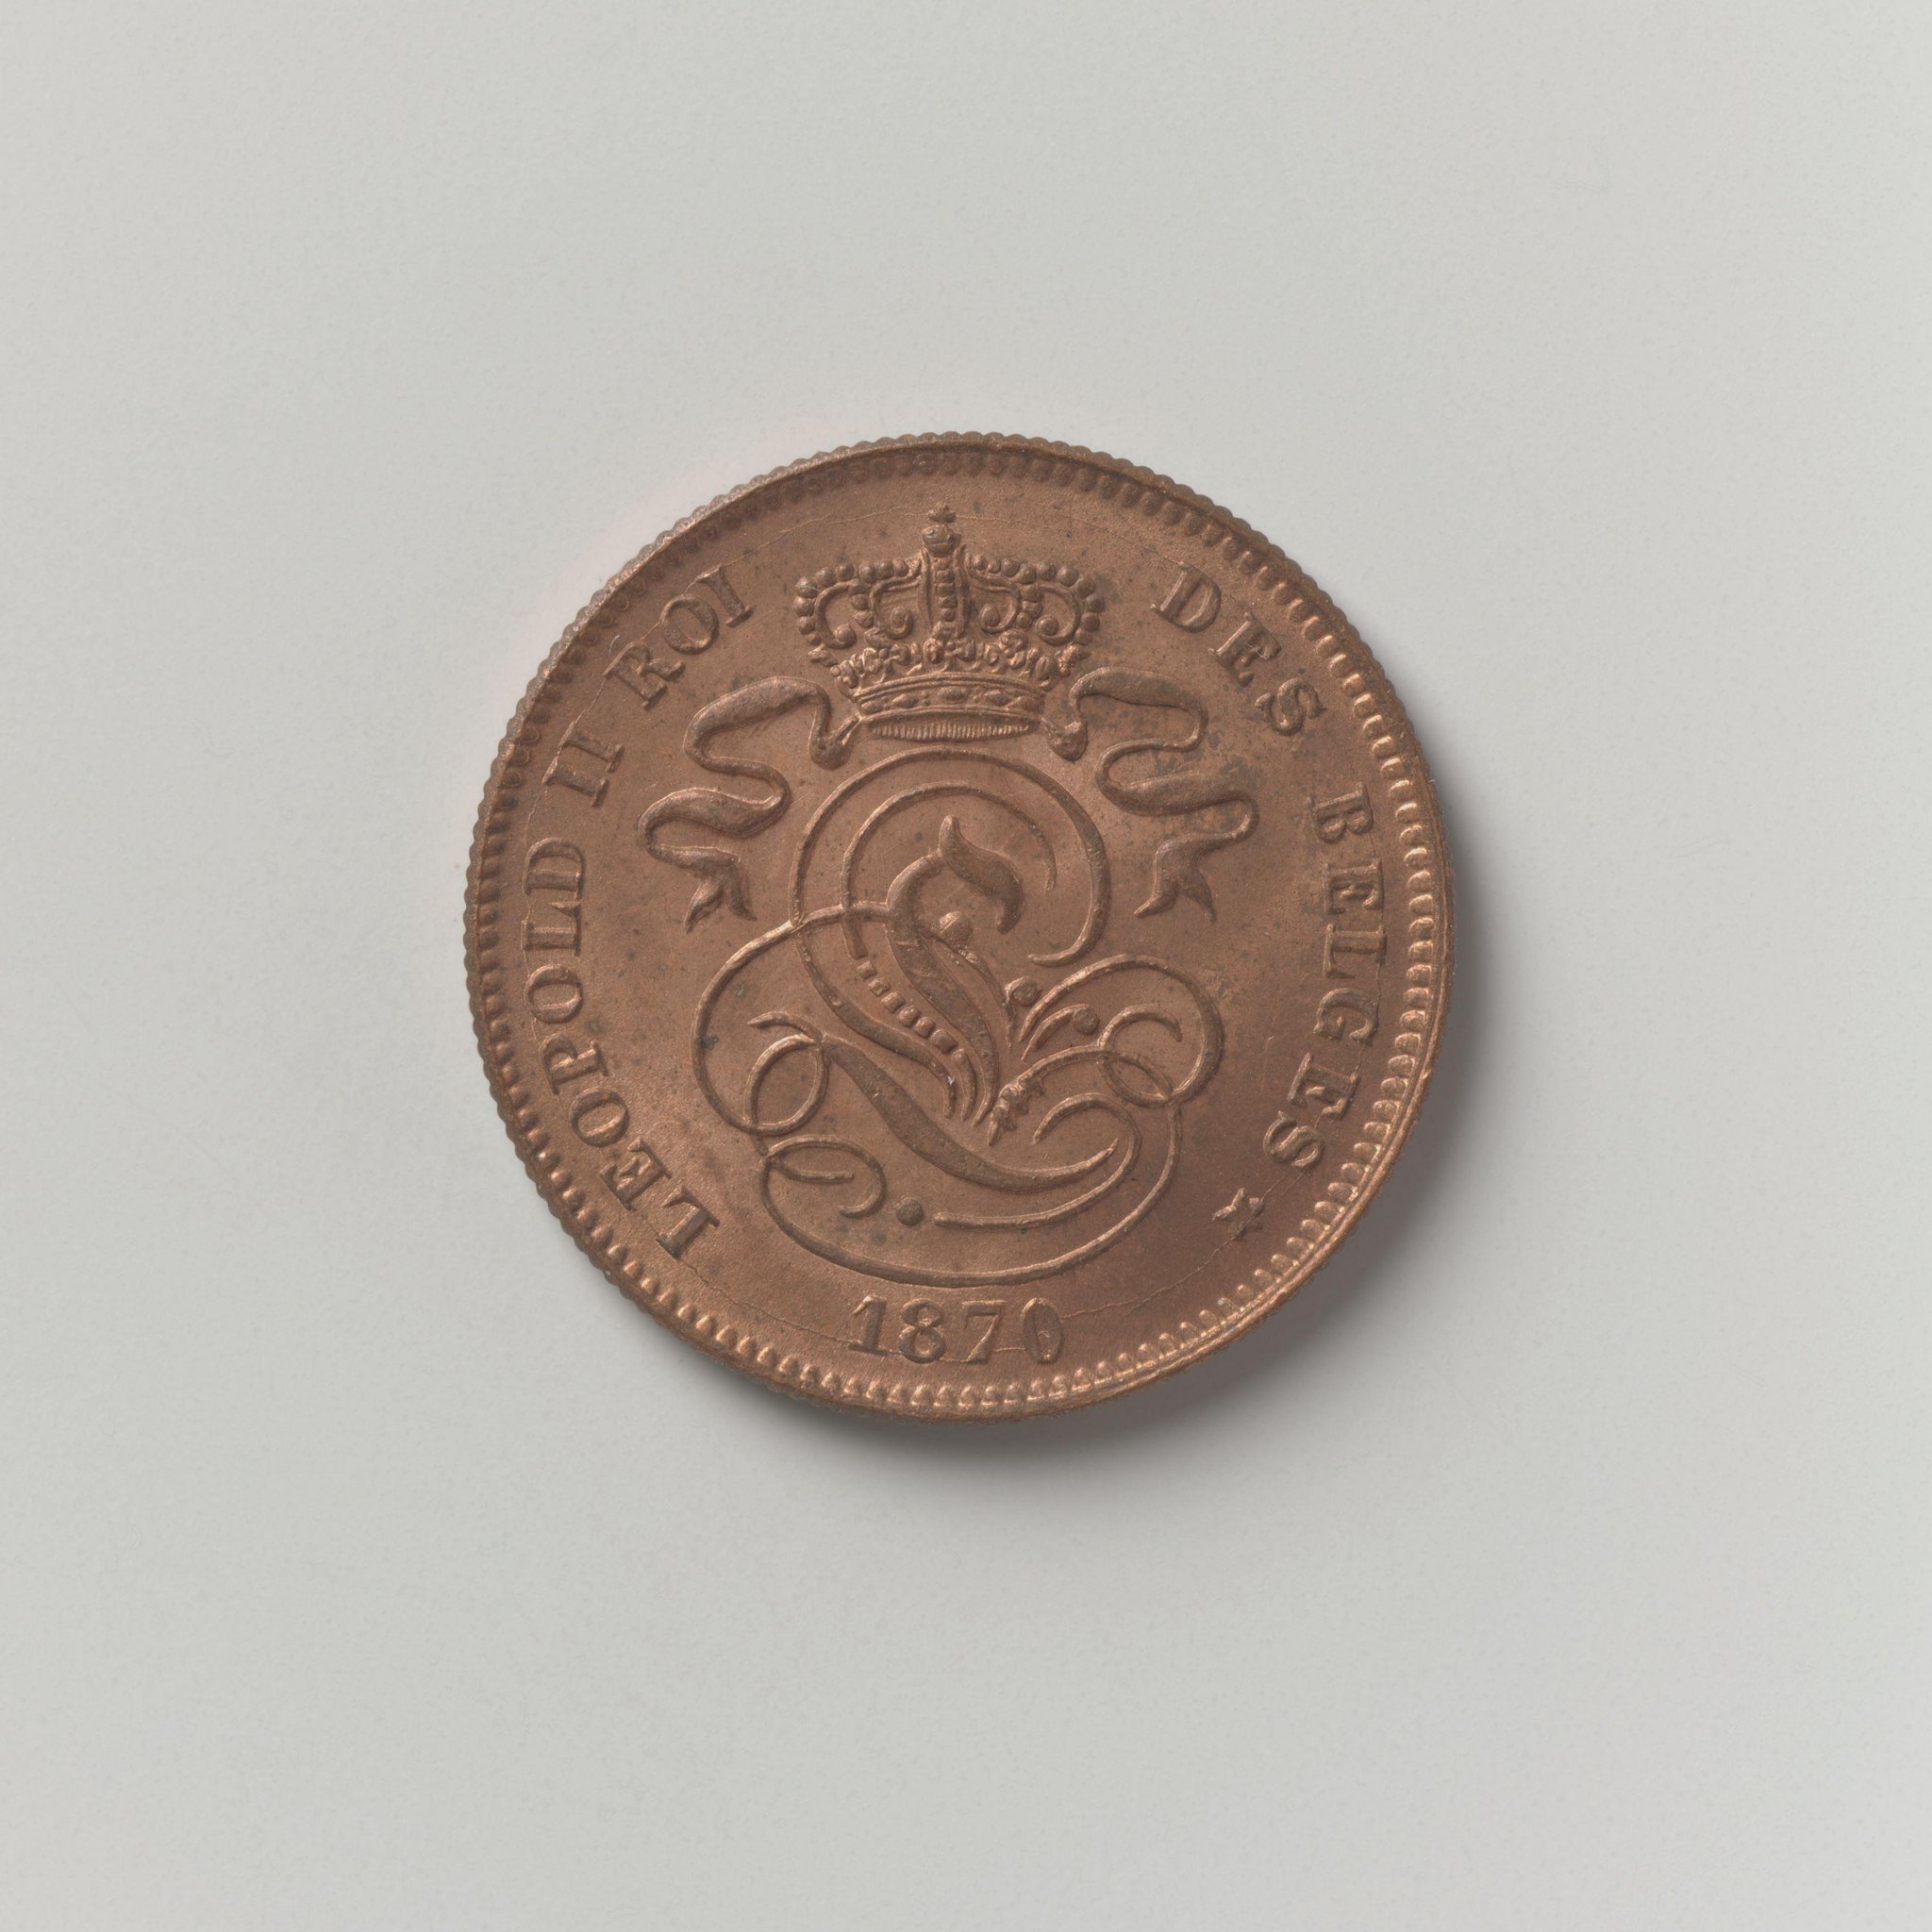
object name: twee centime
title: 2 centimes uit België van Leopold II, 1870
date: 1870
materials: copper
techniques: striking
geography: brussels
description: Koperen munt. Voorzijde: zittende, omkijkende leeuw naar links met onder rechter klauw paneel met opschrift. In afsnede waarde-aanduiding. Keerzijde: gekroond monogram. Jaartal onderaan. Kartelrand.